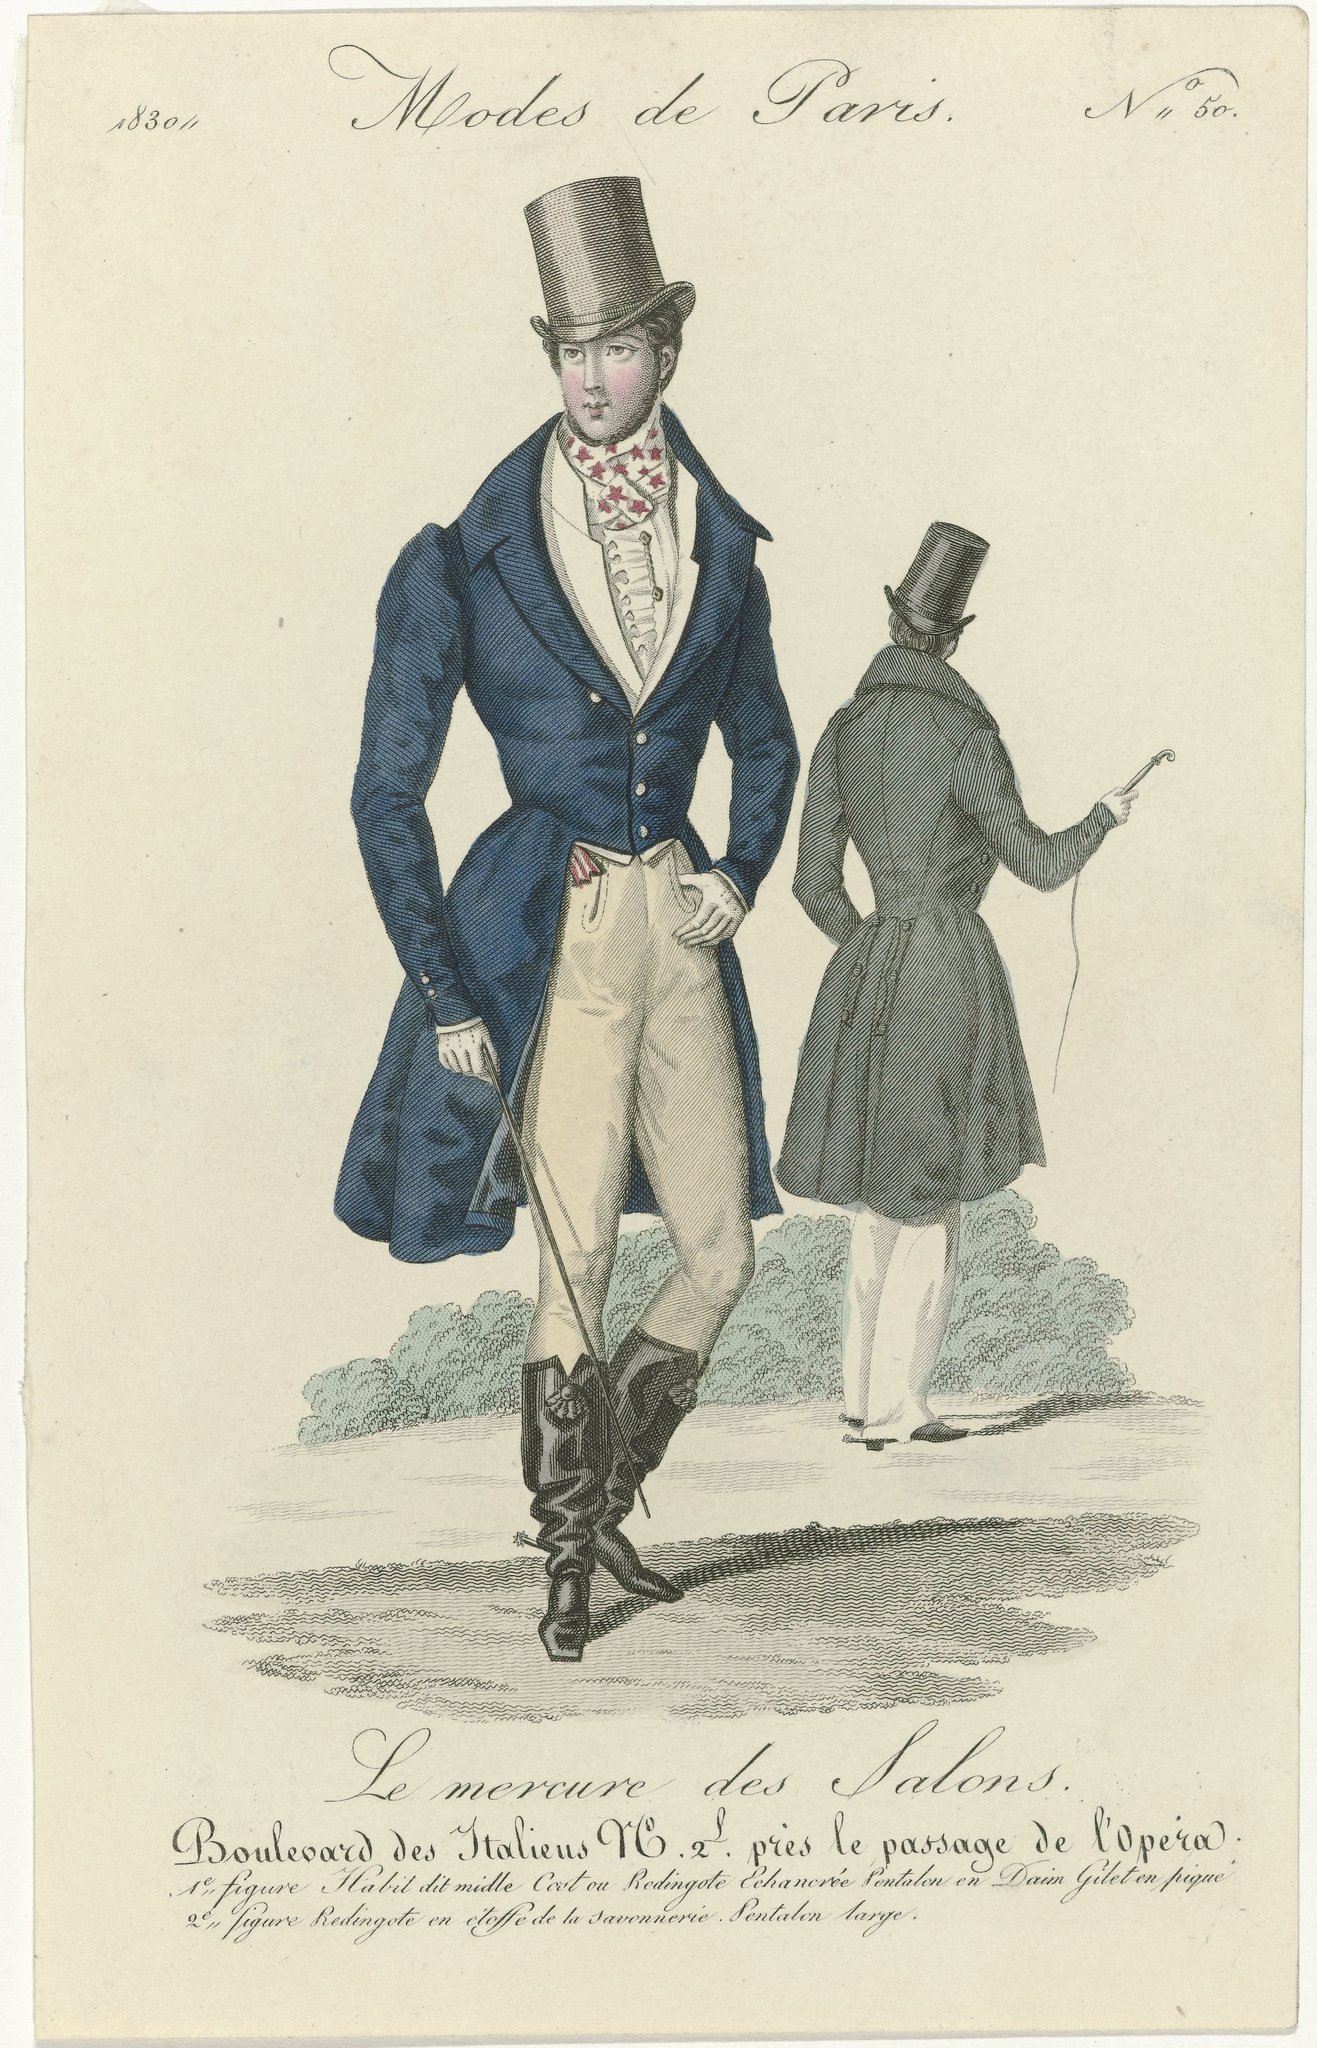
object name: fashion print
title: Le Mercure des Salons, Modes de Paris, 1830, No. 50: 1e figure Habit dit midl (...)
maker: Anonymous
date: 1830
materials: paper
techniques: engraving, hand coloring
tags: clothing for the upper part of the body (vest) (+ men's clothes), trousers, breeches, etc. (pantalon) (+ men's clothes), coat (+ men's clothes), fashion plates, boots (+ men's clothes), gloves, mittens, etc. (+ men's clothes), whip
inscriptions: caption: ‘1e figure Habit dit midle Cost ou Redingote Echancrée Pentalon en Daim Gilet en piqué 2e "figure Redingote en étoffe de la savonnerie. Pentalon large.’, title: ‘Le Mercure des Salons.’, address: ‘Boulevard des Italiens No. 2l. près le passage de l'Opéra.’, title: ‘Modes de Paris.’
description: Eerste figuur: 'habit', genaamd 'midle Cost' of redingote met een laag uitgesneden hals. Lange broek van suéde. Vest van piqué. Geknoopte halsdoek met patroon van sterren. Gerimpelde jabot. Accessoires: hoge hoed met opstaande rand, dasspeld(?), handschoenen, wandelstok, laarzen met kwasten, sporen en vierkante neuzen. Tweede figuur: redingote van 'étoffe de la savonnerie.' Wijde lange broek. Schoenen met hakken en sporen. Hoge hoed. Zweep. Prent uit het modetijdschrift Le Mercure des Salons (janvier 1830 - mars 1831).